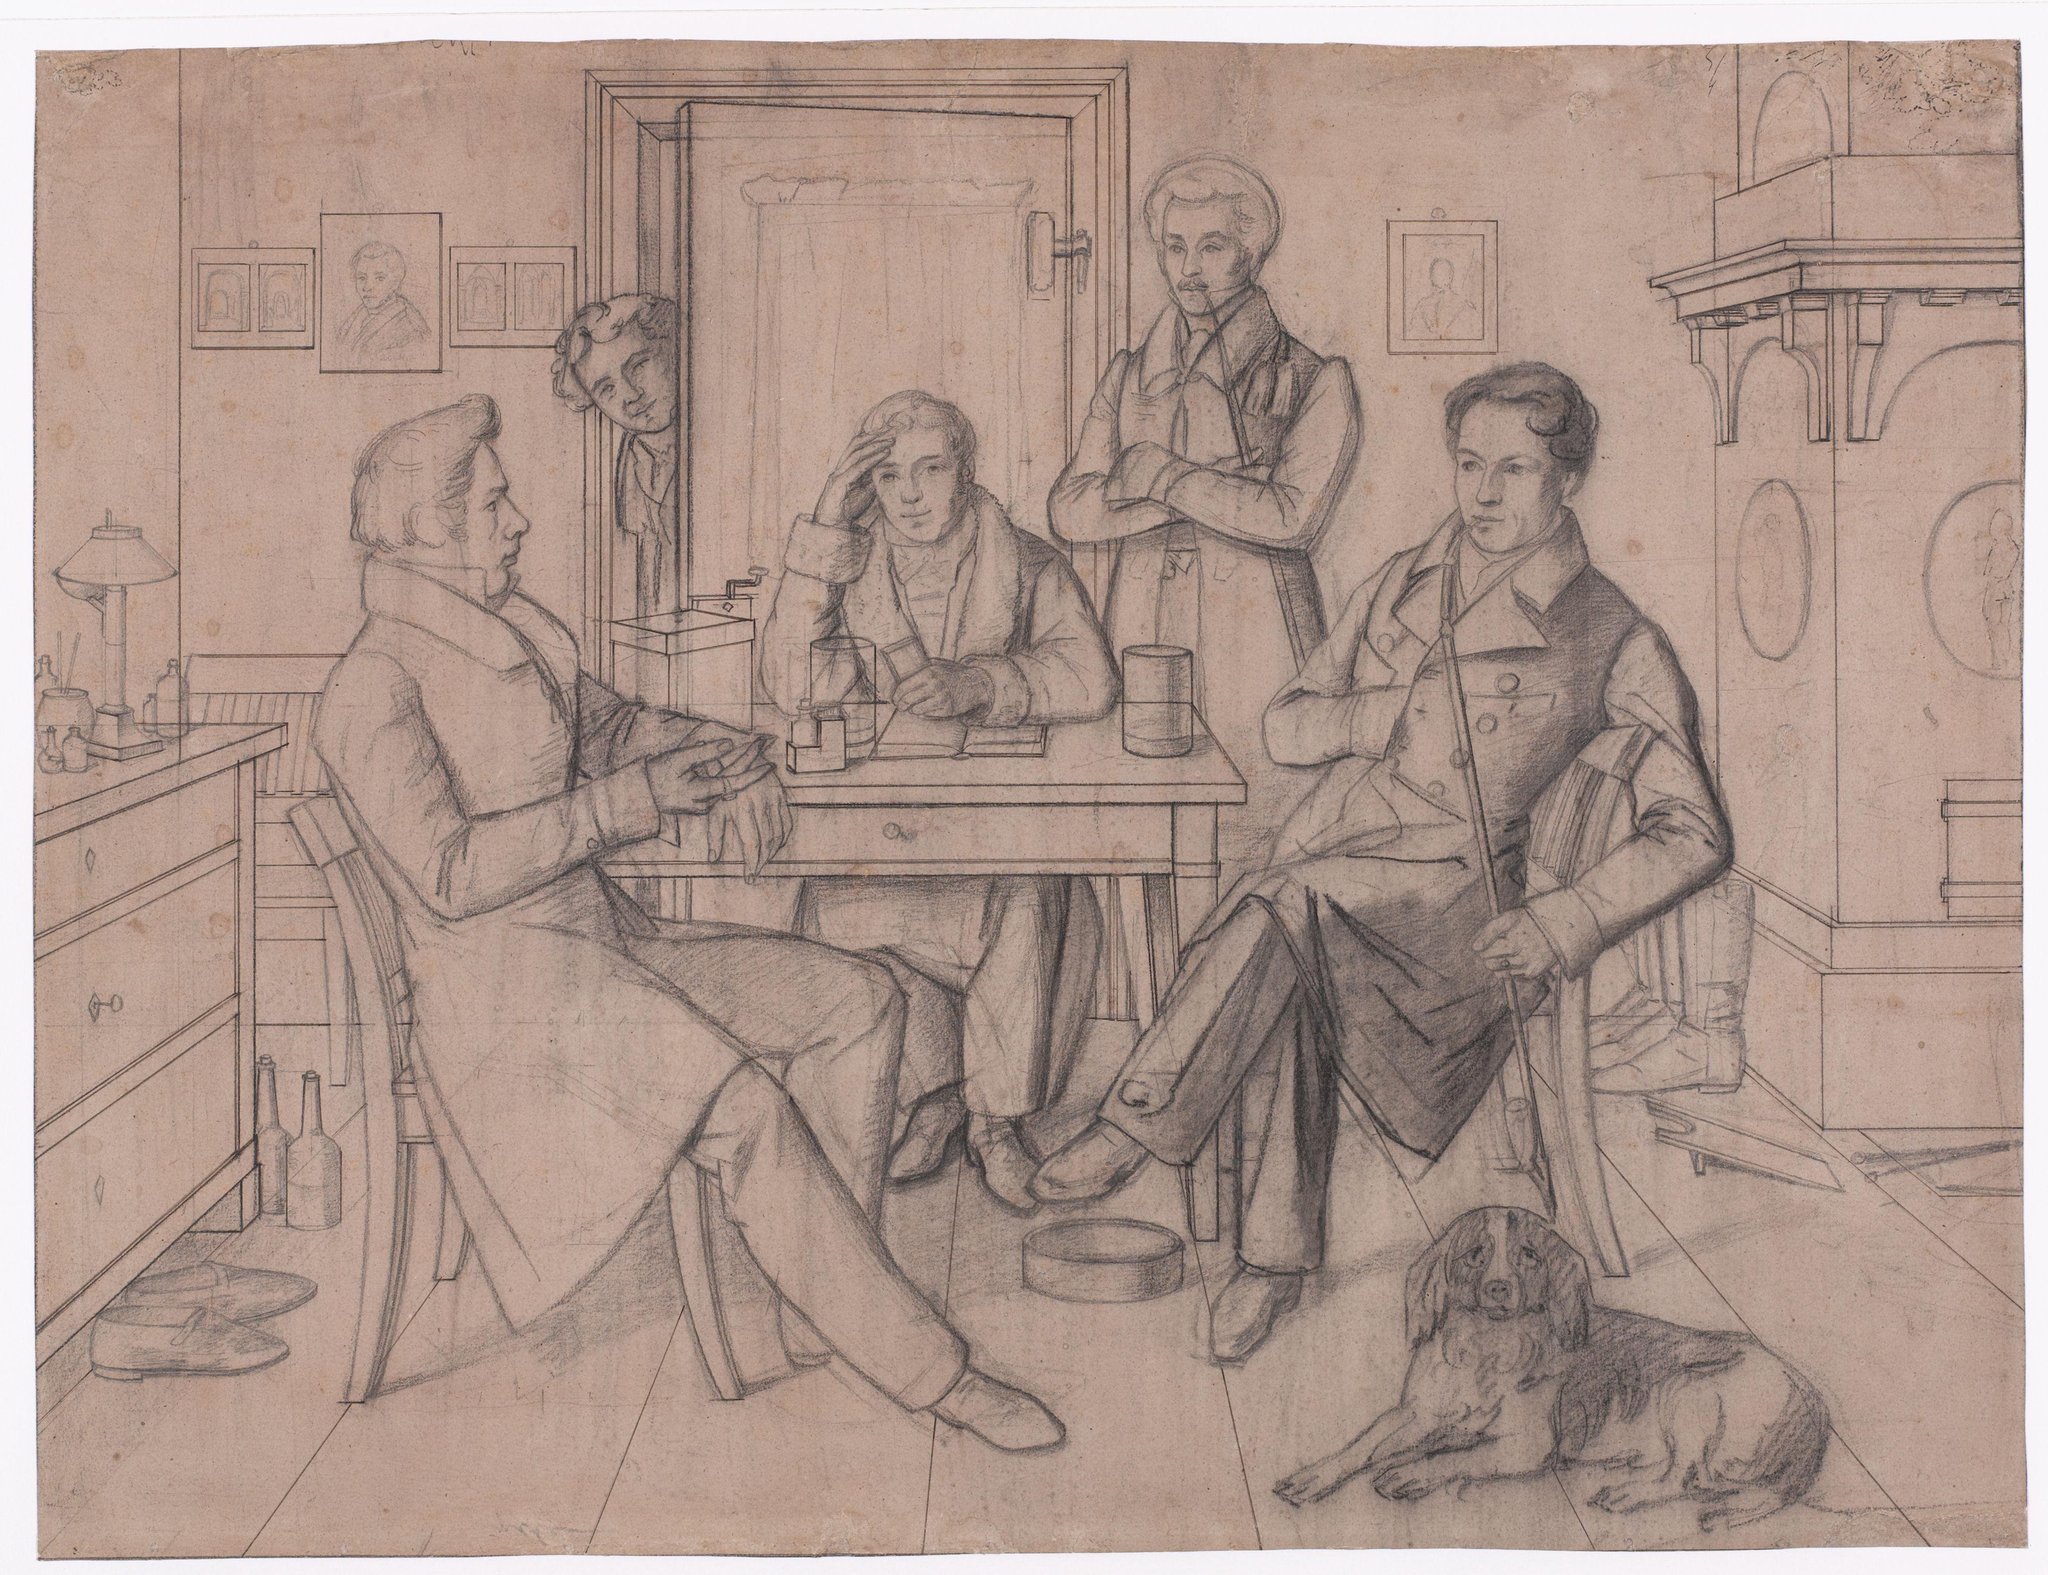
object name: drawing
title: Studentenkamer met drie zittende en twee staande mannen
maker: Anonymous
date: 1800-1900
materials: chalk, ink, paper, pencil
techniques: pen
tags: student room, communal rooms, student life